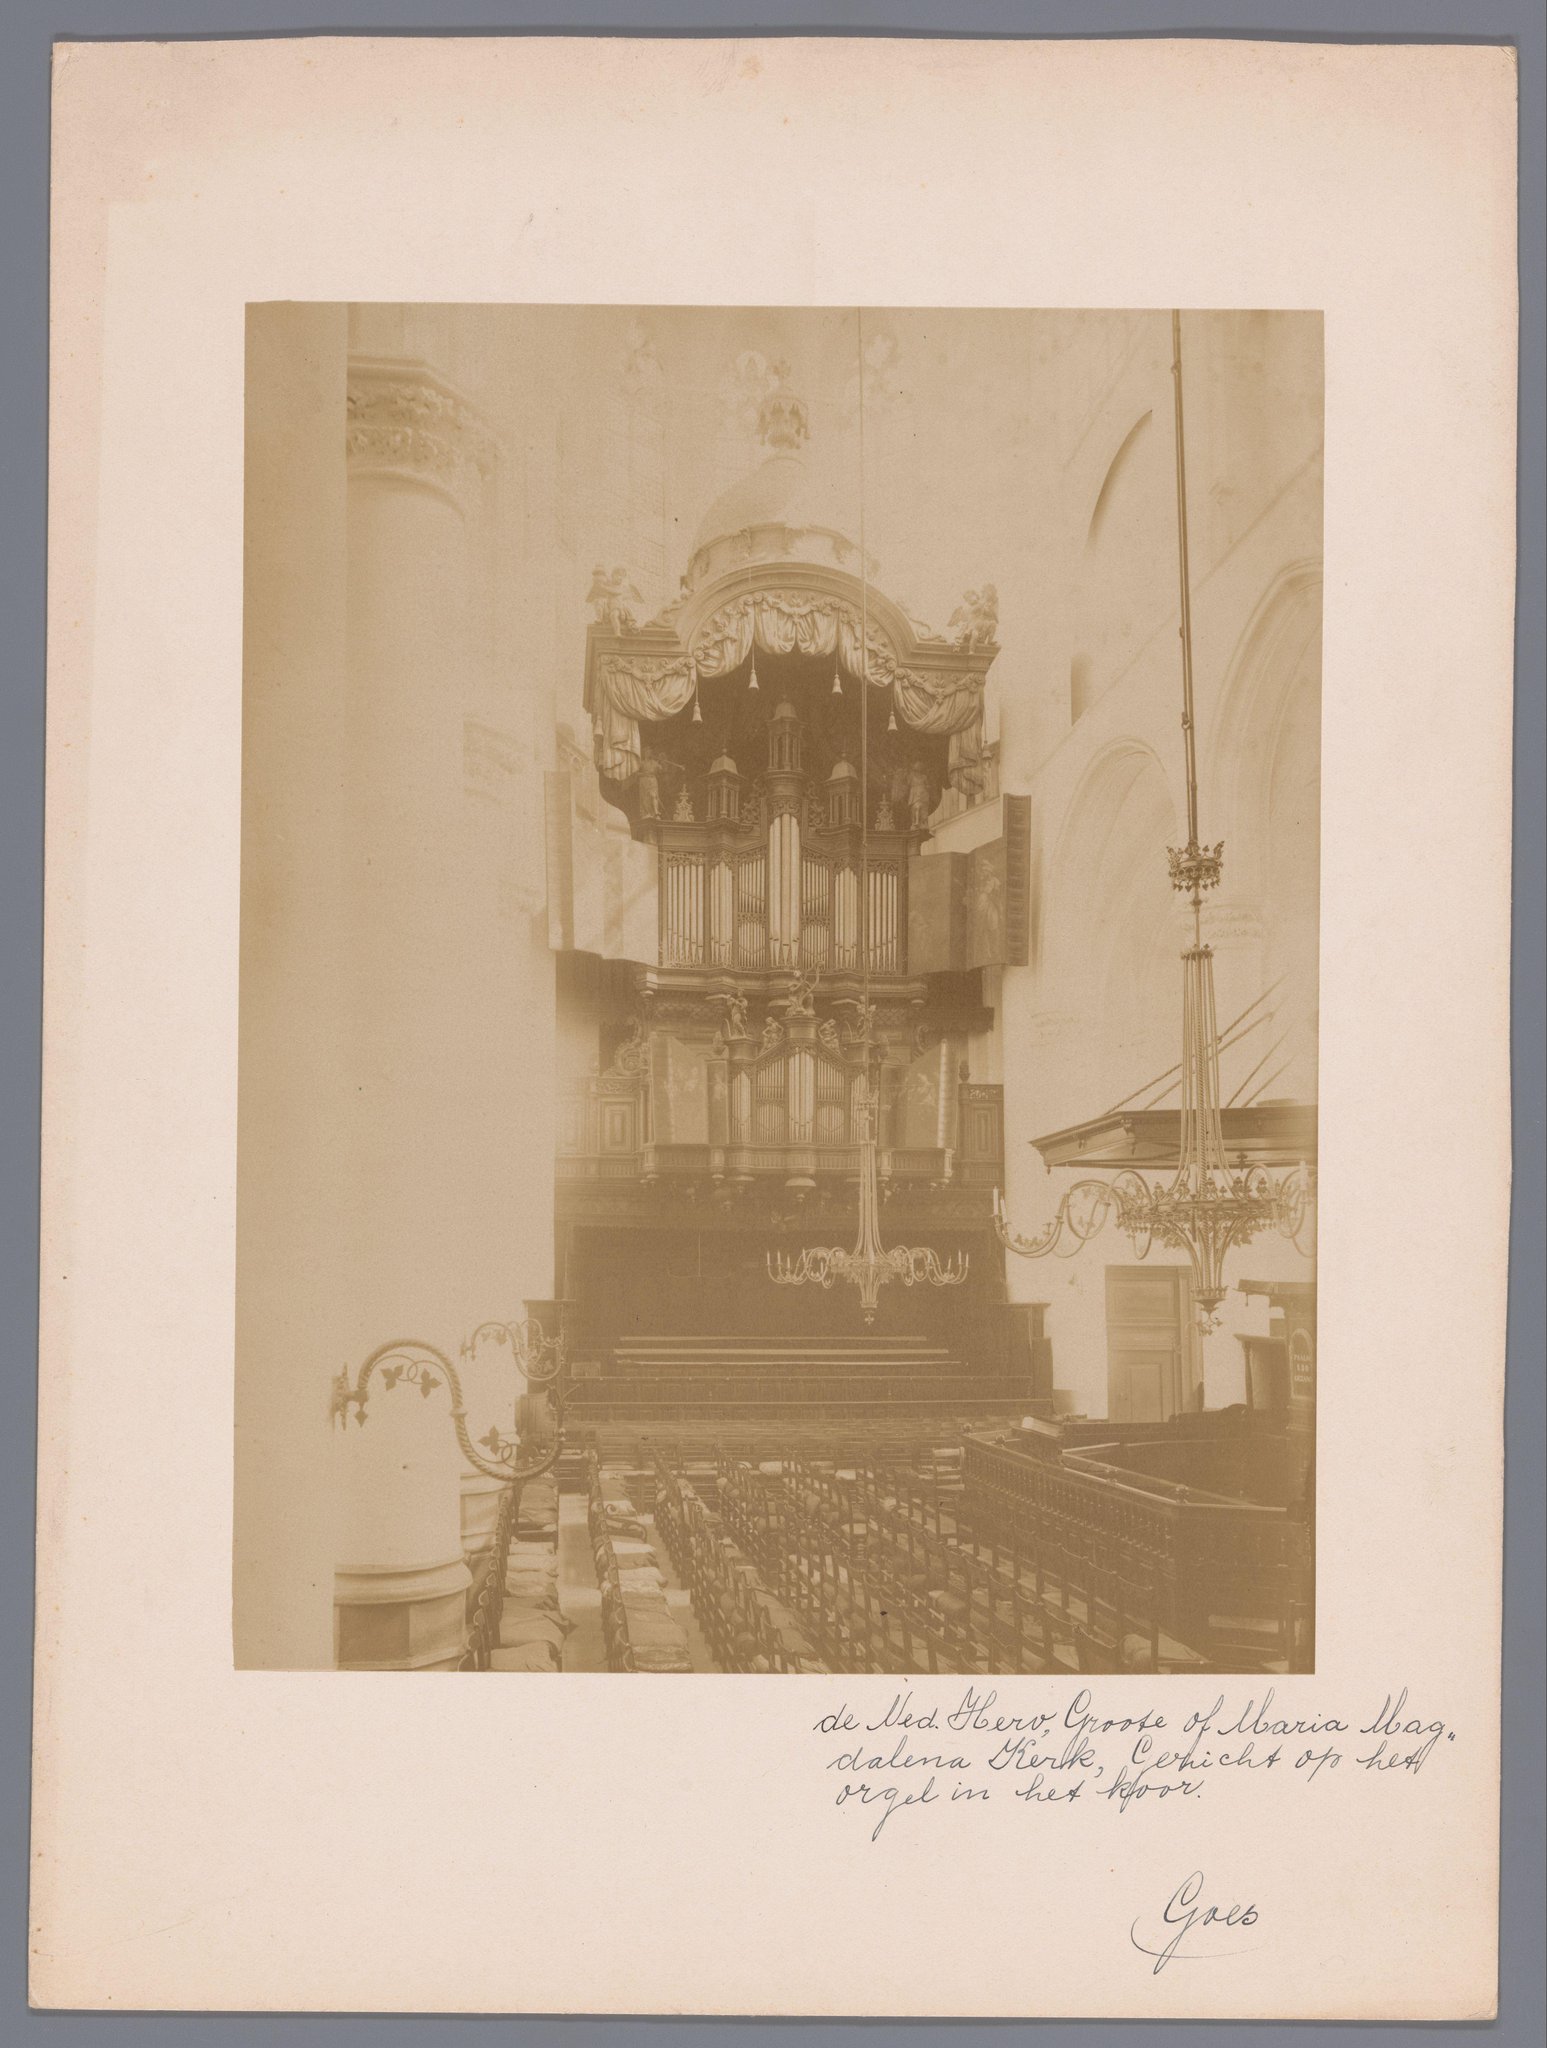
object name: photograph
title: Orgel in de Grote of Maria Magdalenakerk te Goes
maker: anoniem (monumentenzorg)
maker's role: fotograaf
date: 1890-1920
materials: cardboard, photographic support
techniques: albumen print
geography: grote kerk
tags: church organ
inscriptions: annotation: ‘groote of St. Magdalenakerk te Goes/ Gezicht op het orgel in het koor/ orgel 1643 gemaakt (...)’, annotation: ‘de Ned. Herv, Groote of Maria Magdalena Kerk, gezicht op het orgel in het koor/ Goes’